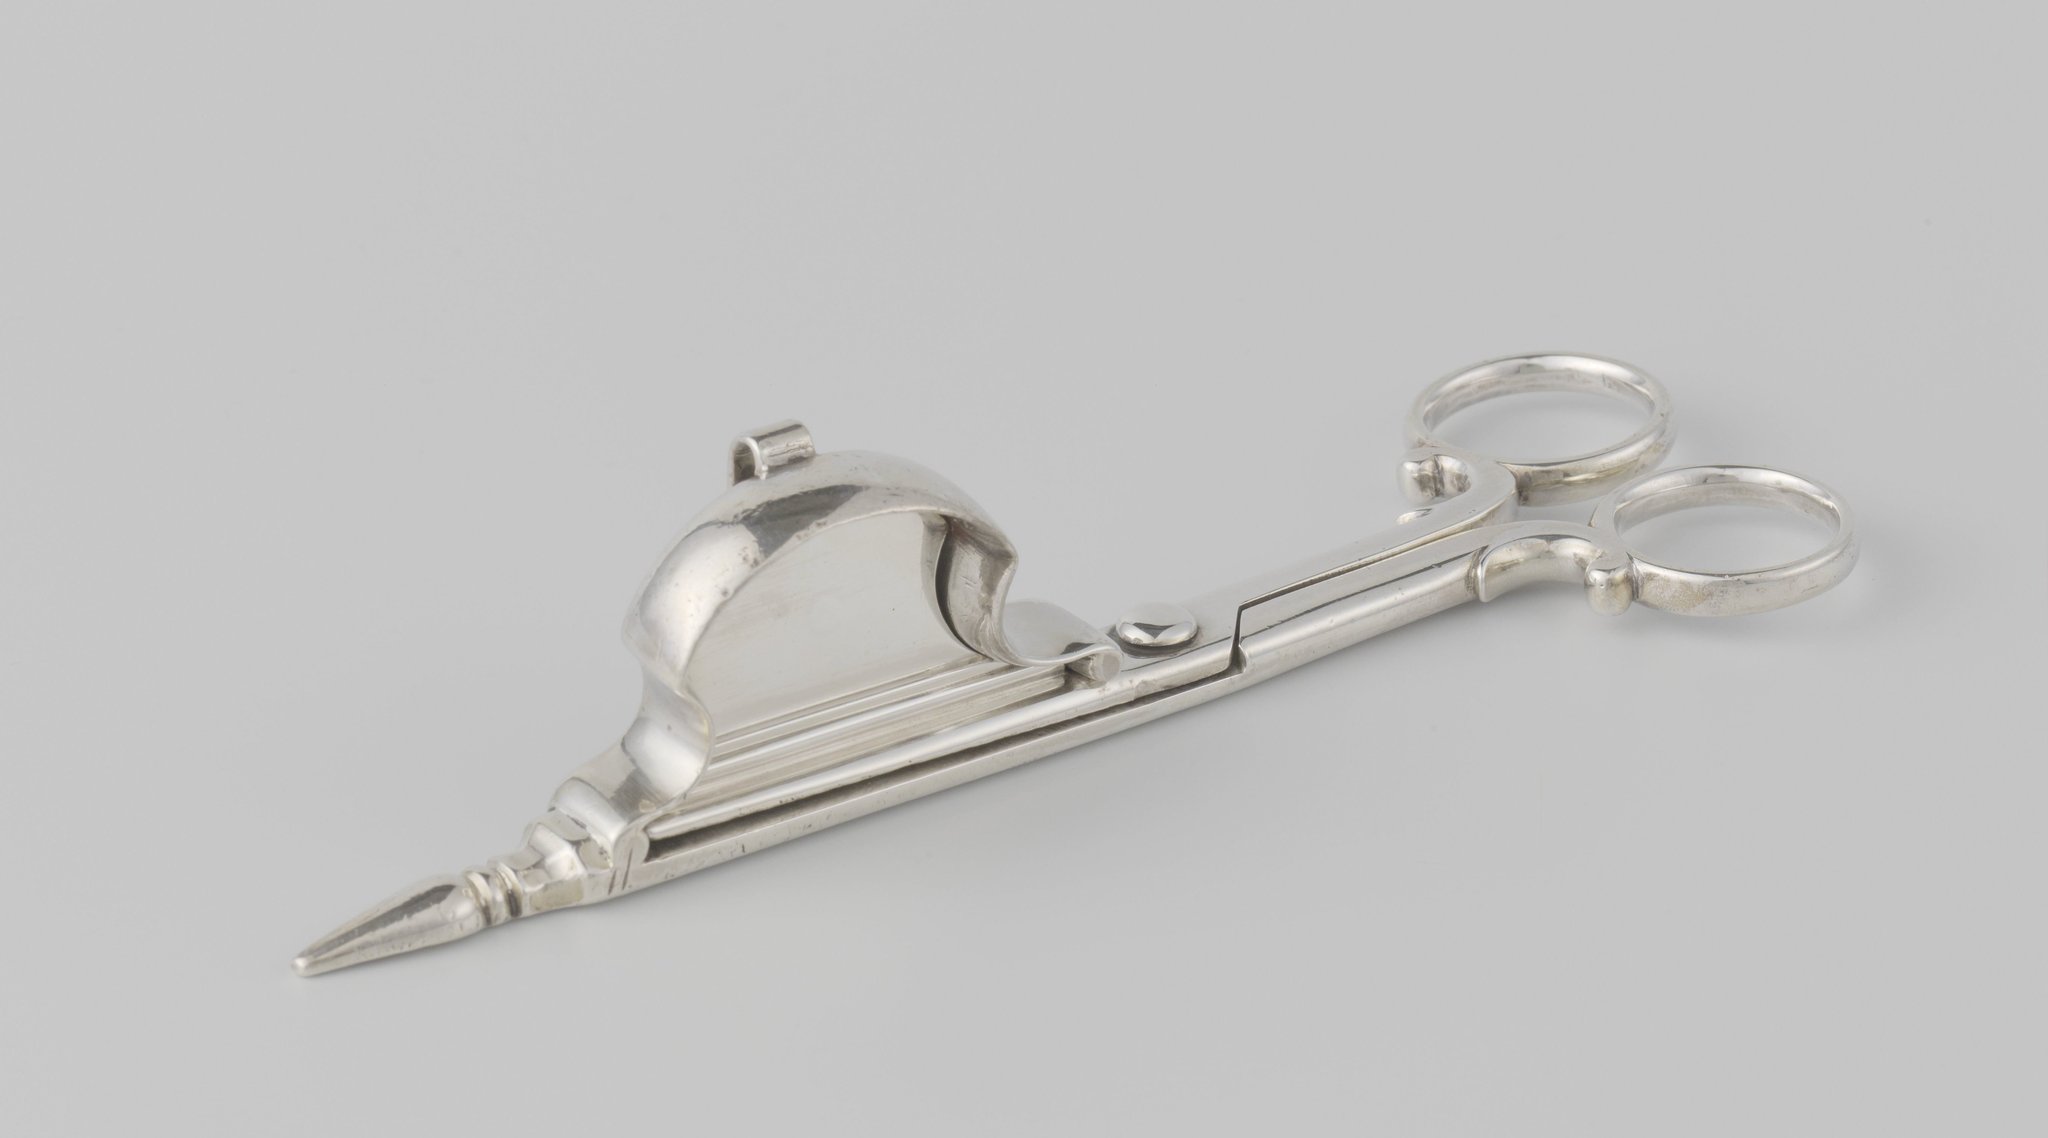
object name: snuiter, snuiterschaar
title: Snuiter van zilver in de vorm van een schaar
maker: Anonymous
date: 1717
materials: silver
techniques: casting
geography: the hague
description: Snuiter van zilver in de vorm van een schaar met een bakje aan het uiteinde.